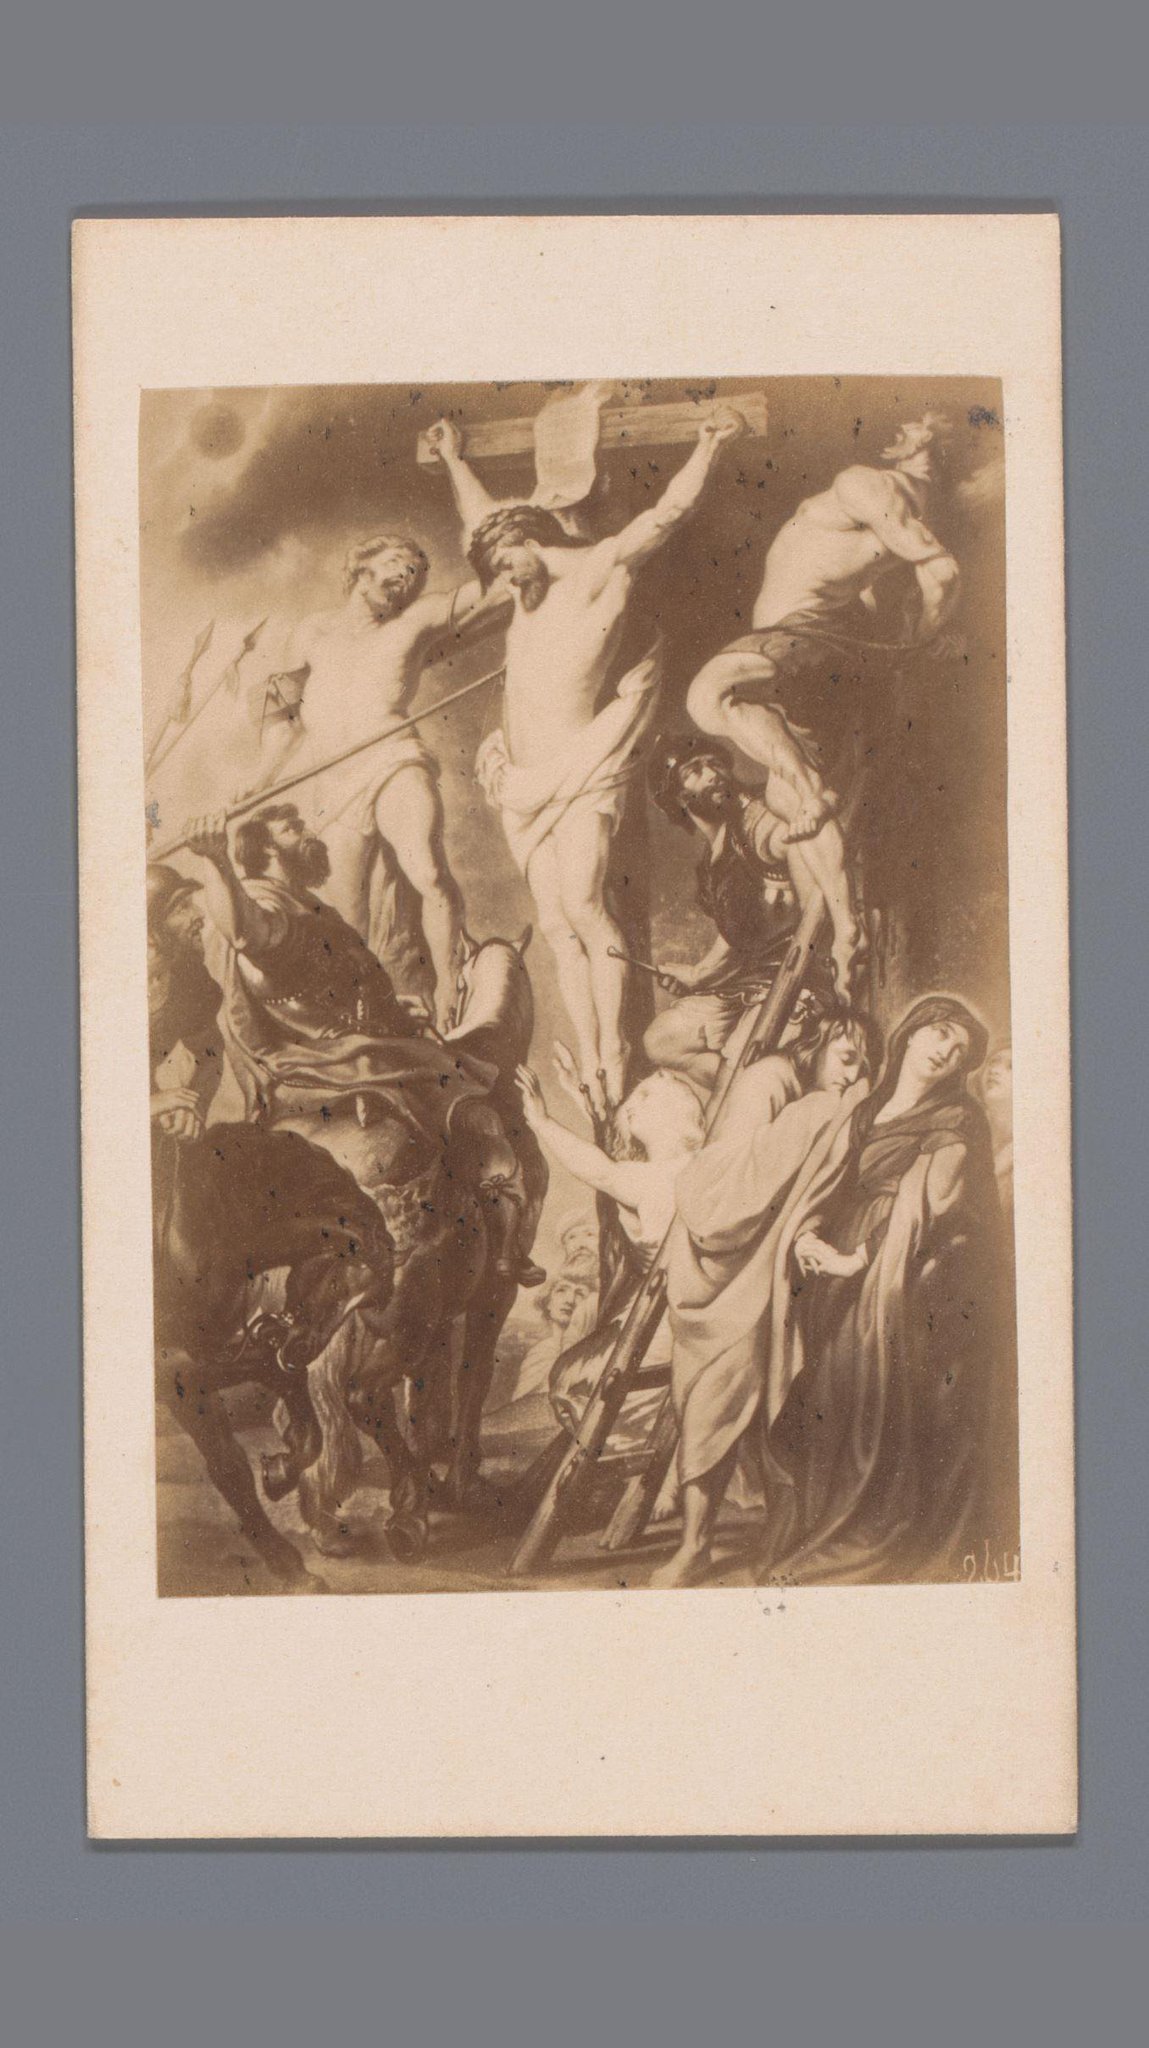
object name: carte de visite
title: Anvers Tableaux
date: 1858-1866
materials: cardboard, paper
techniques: albumen print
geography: antwerp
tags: longinus pierces christ's side with a lance, crucified christ, with particular persons under the cross - dd - the three crosses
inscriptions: number: ‘264’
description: Het oorspronkelijke schilderij van Rubens bevindt zich nu in het Museum voor Schone Kunsten te Antwerpen.